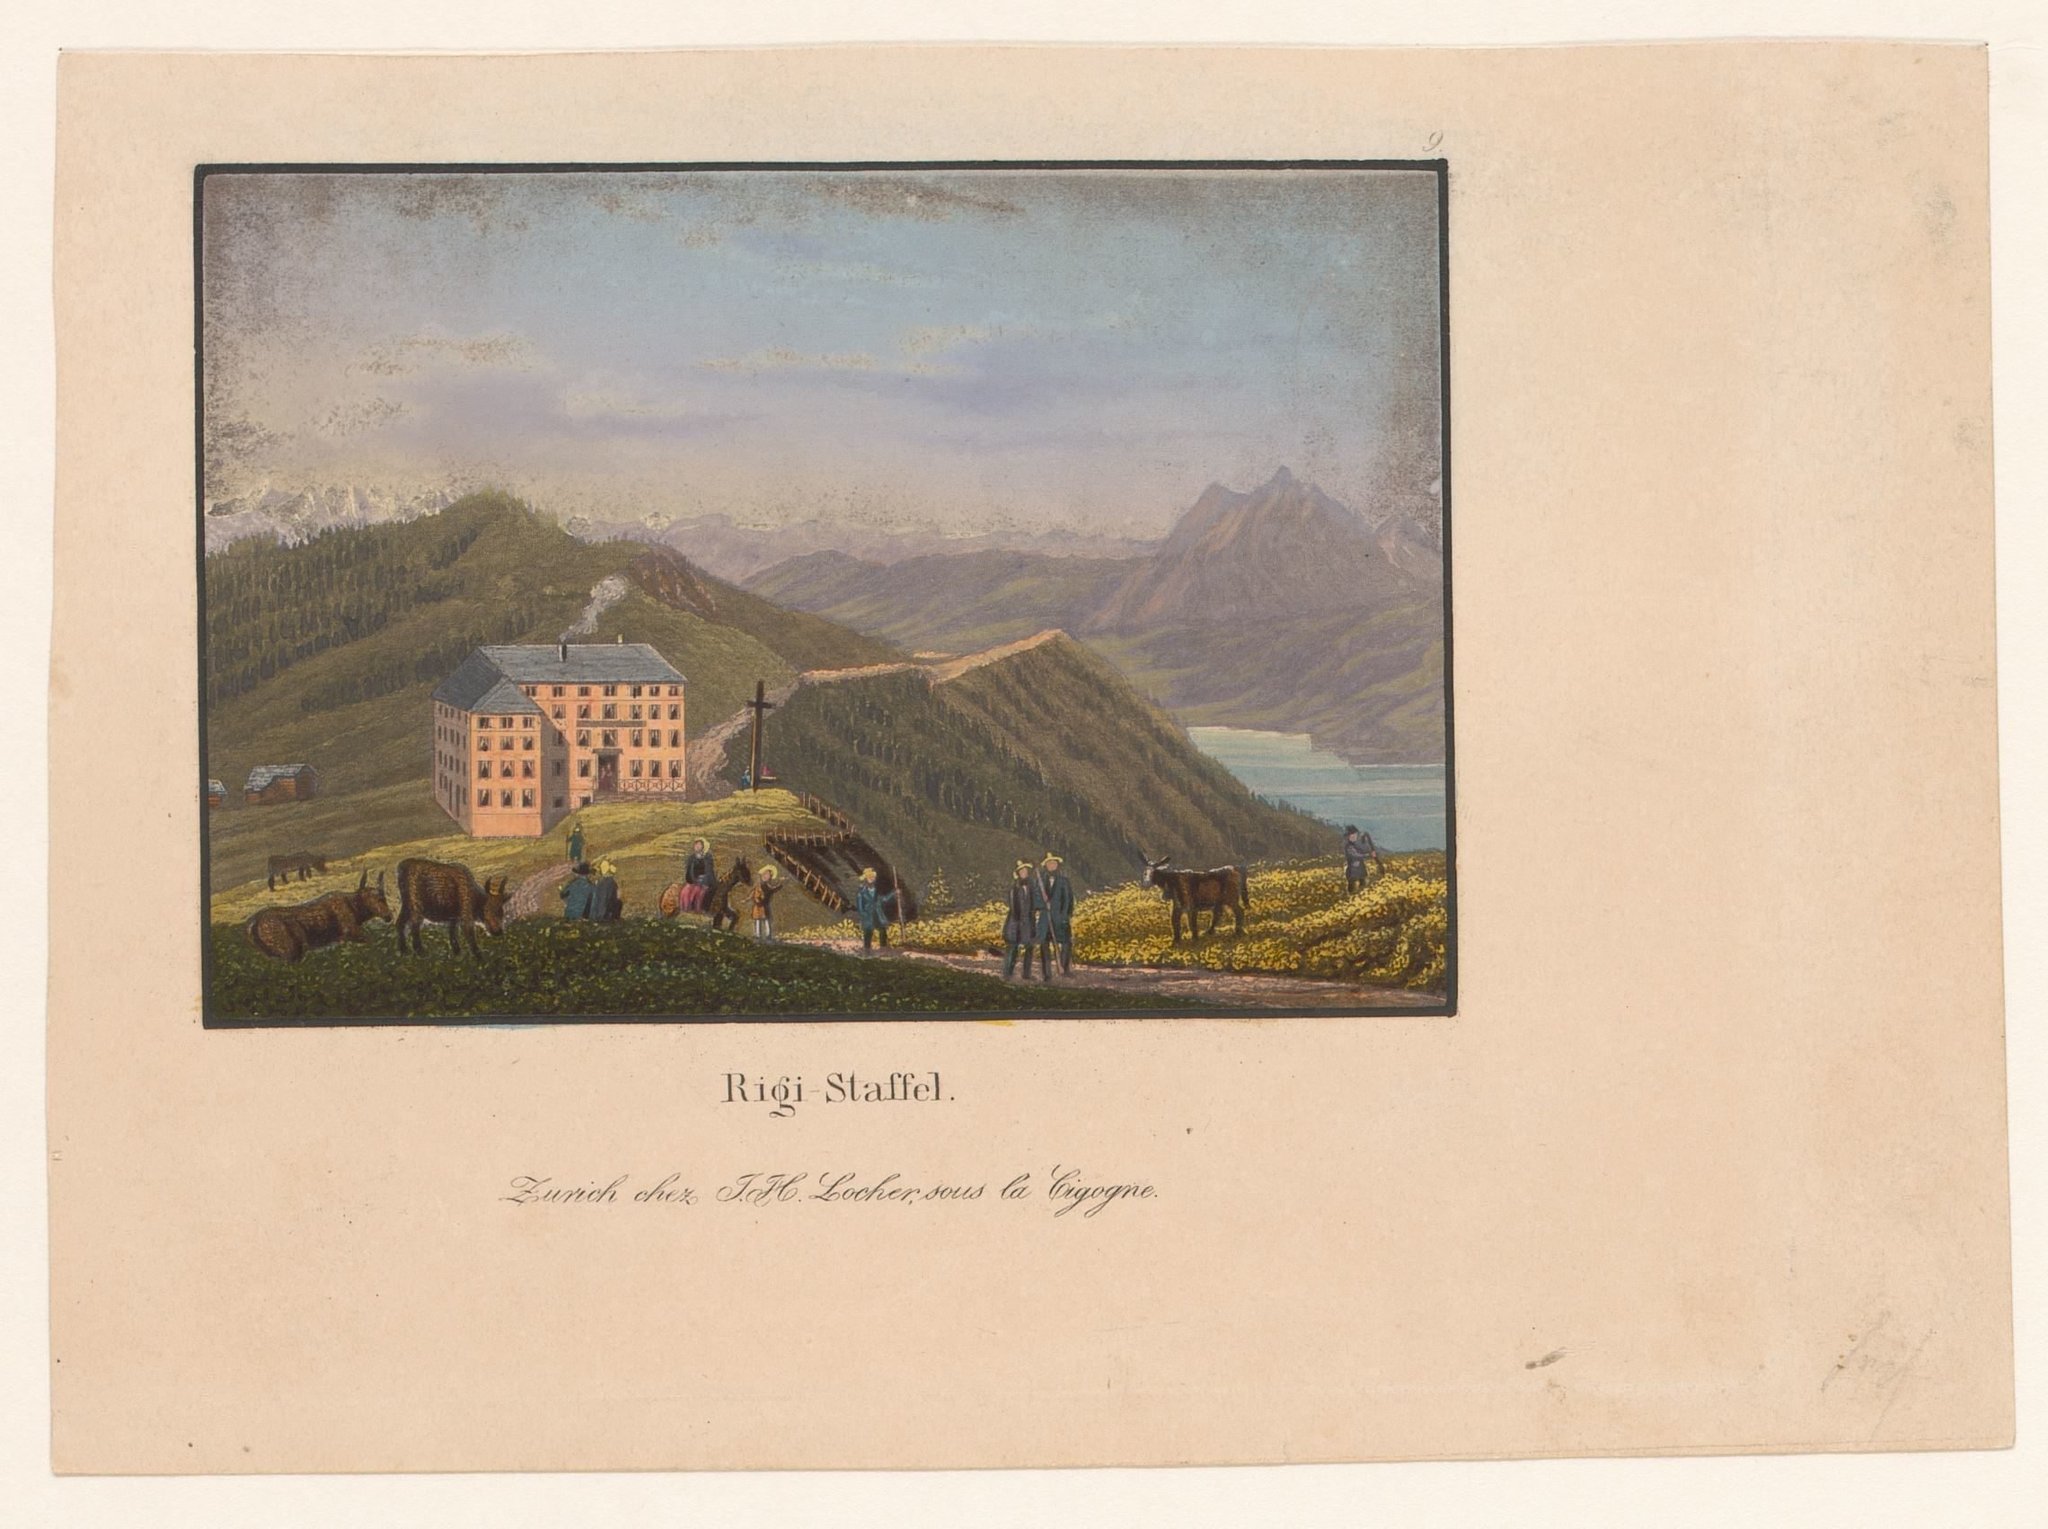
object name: print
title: Gezicht op Rigi Staffel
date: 1820-1892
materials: paper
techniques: aquatint, hand coloring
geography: zurich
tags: prospect of village, silhouette of village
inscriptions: collector's mark: Lugt 2228